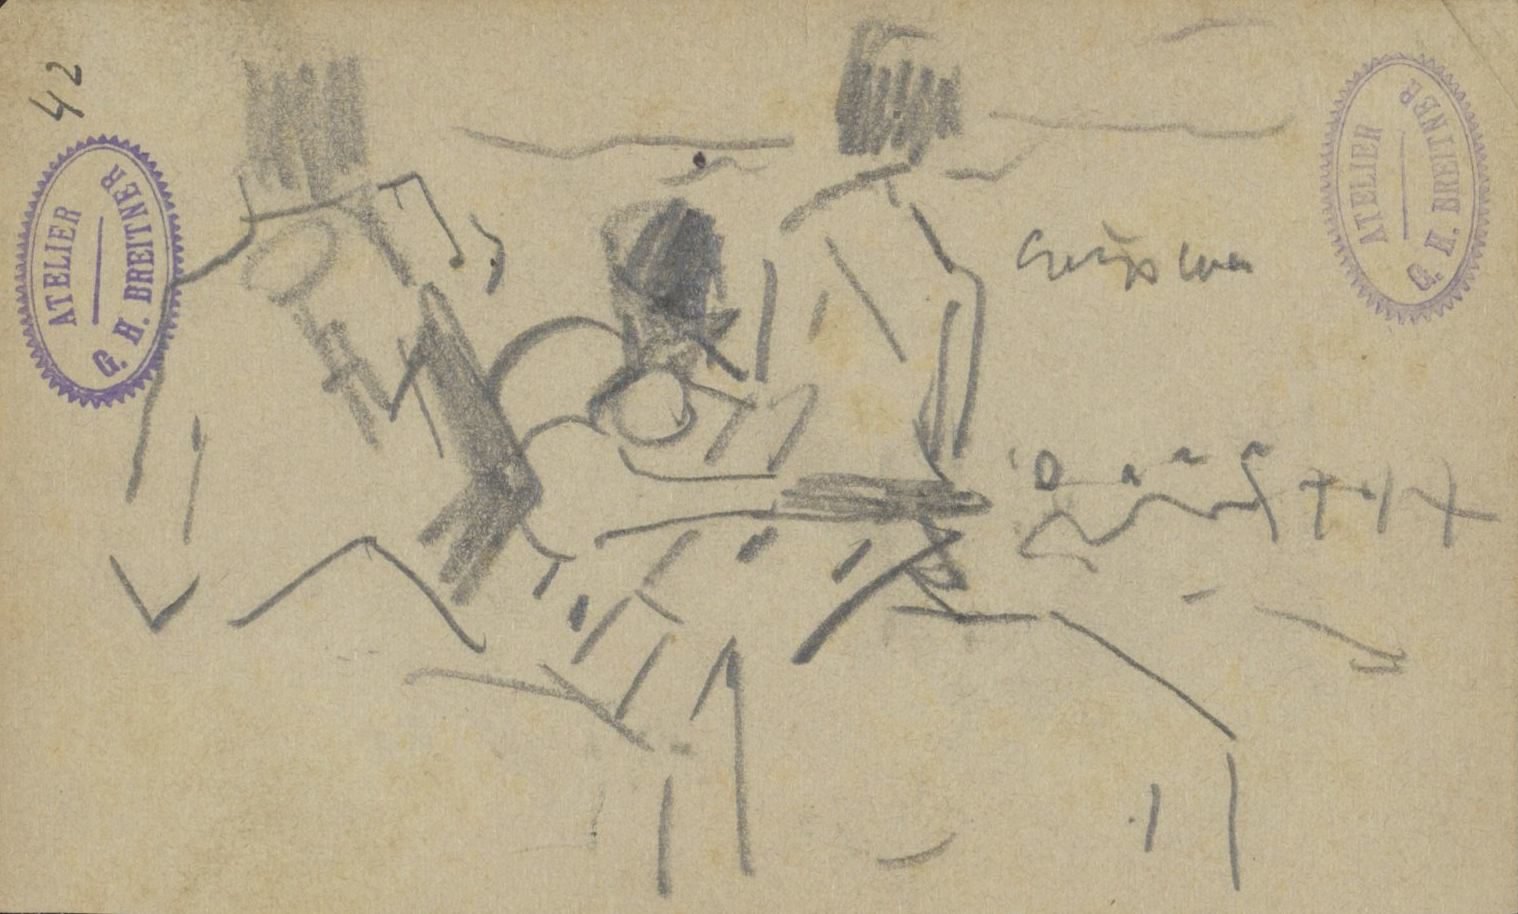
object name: drawing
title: Landschap met drie ruiters, mogelijk huzaren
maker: george hendrik breitner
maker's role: draughtsman, painter, print maker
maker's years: 1857-1923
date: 1887-1891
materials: paper, pencil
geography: gelderland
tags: private soldier (+ cavalry, horsemen), landscapes in the temperate zone (+ landscape with figures, staffage)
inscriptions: workshop stamp: Lugt 291d